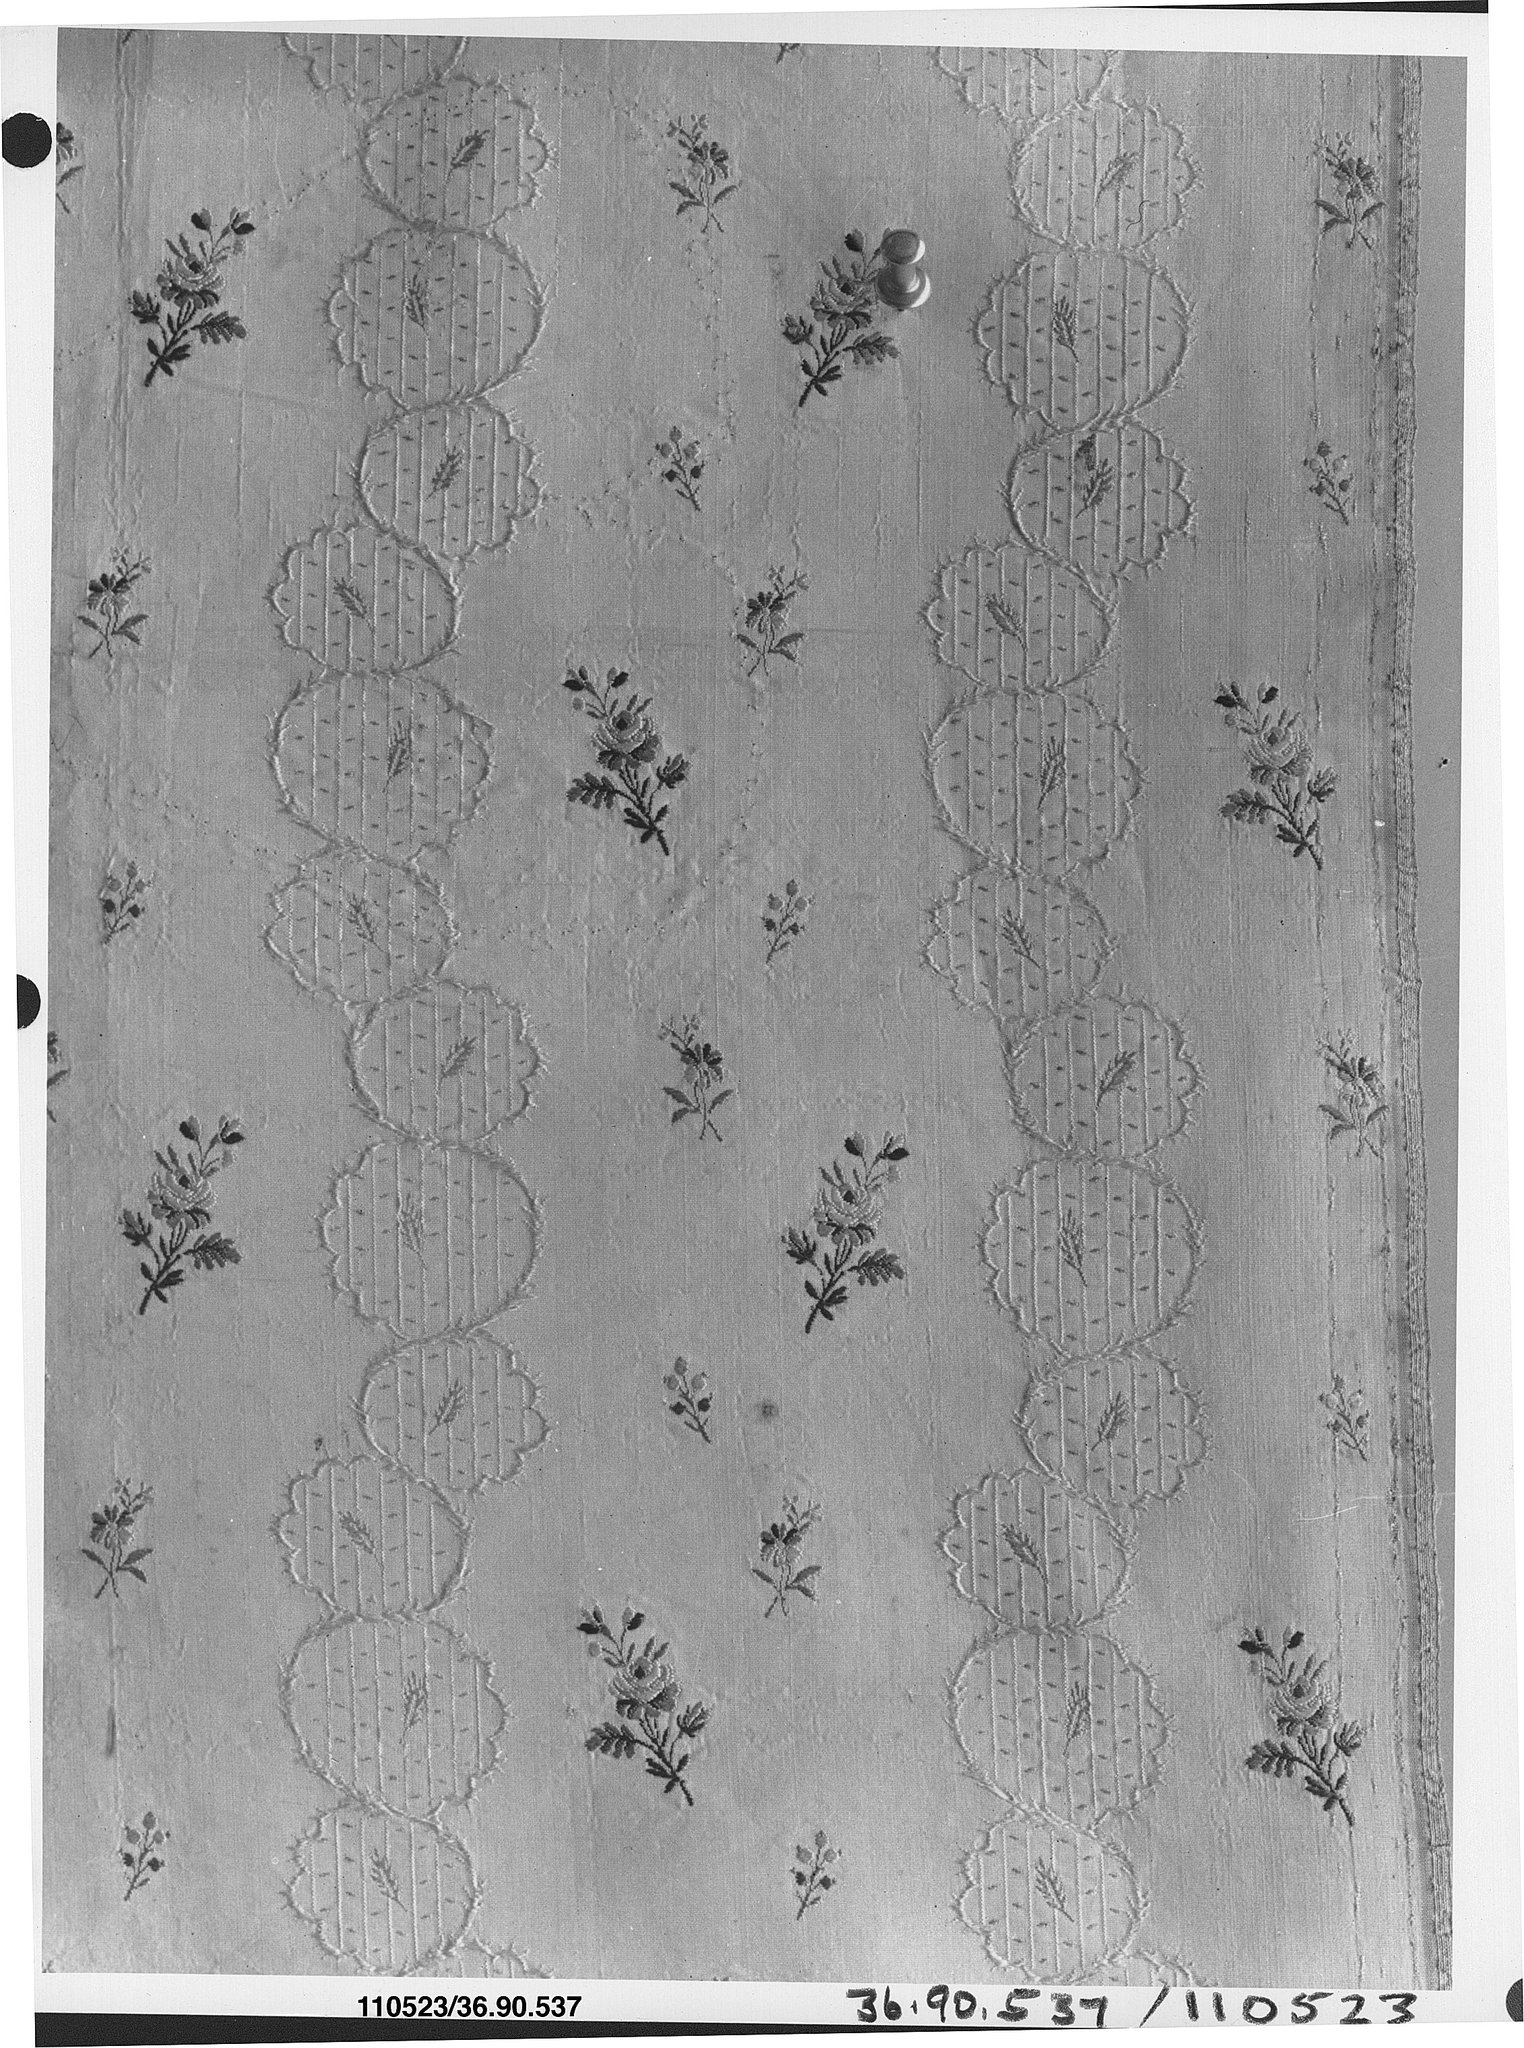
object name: piece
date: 1767-1800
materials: silk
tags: flowers,leaves